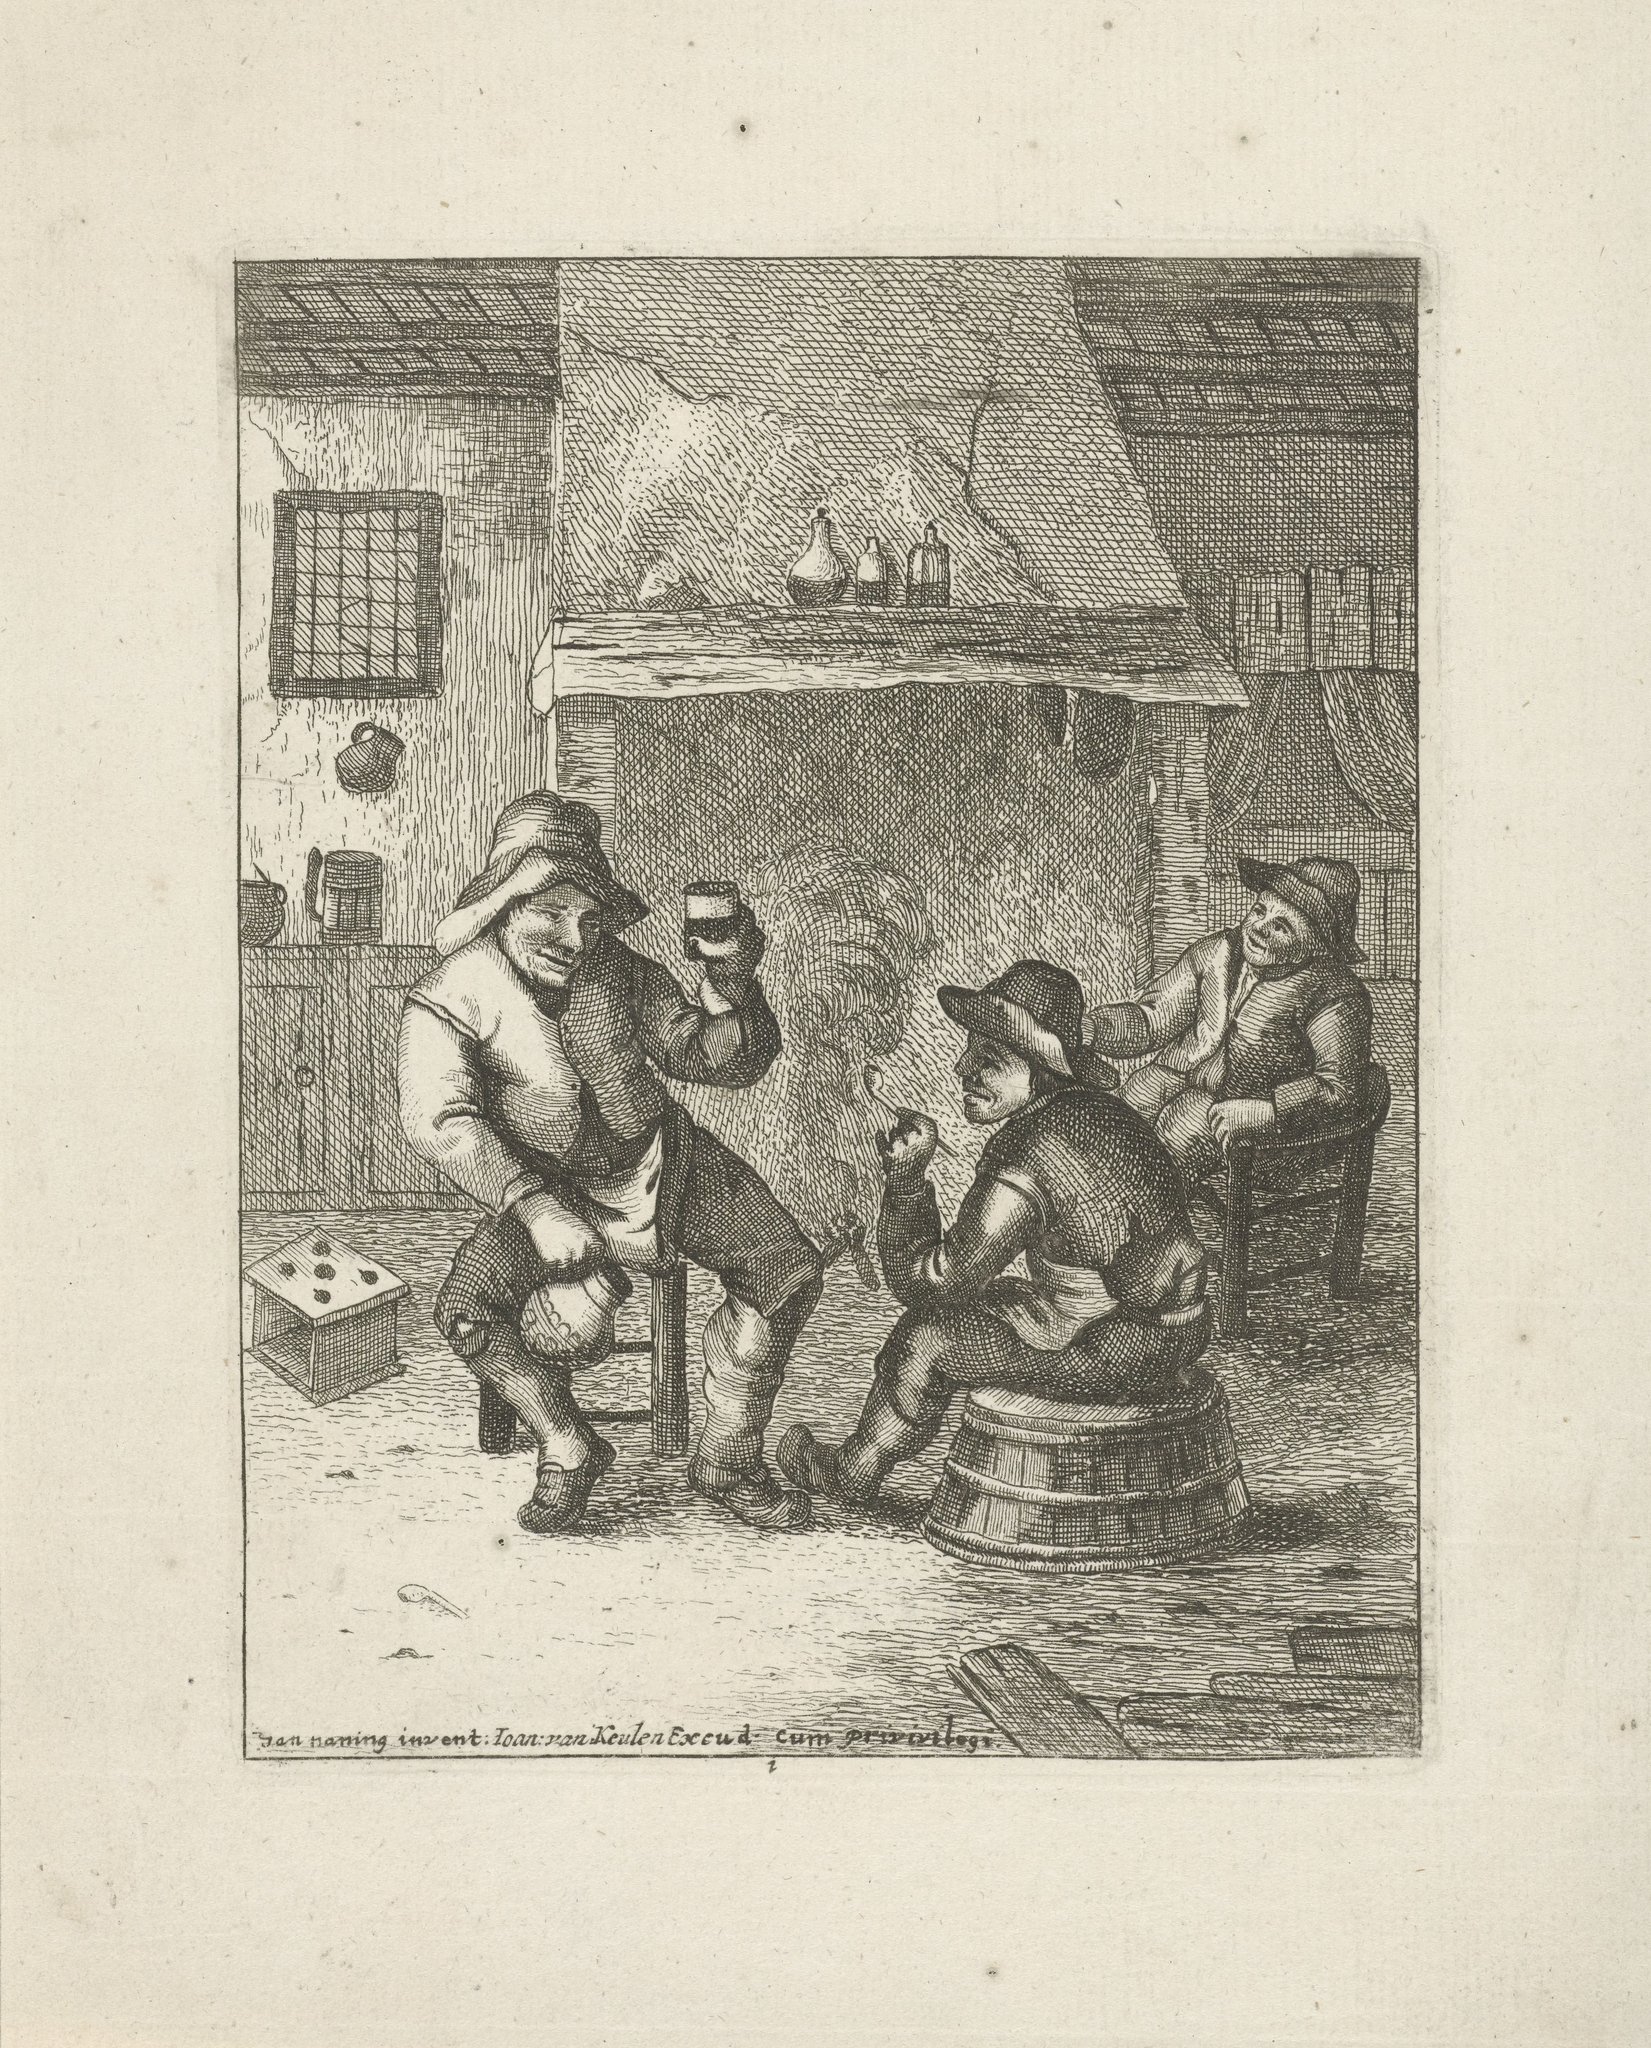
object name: print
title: Boeren in interieurs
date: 1650-1699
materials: paper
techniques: etching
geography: amsterdam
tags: farmers, farm (building) - aa - civic architecture: inside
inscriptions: collector's mark: Lugt 2760, collector's mark: Lugt 2228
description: Drie boeren bij de haard. De boer links heft zijn glas en houdt een kruik in de andere hand, de middelste boer rookt een pijp.